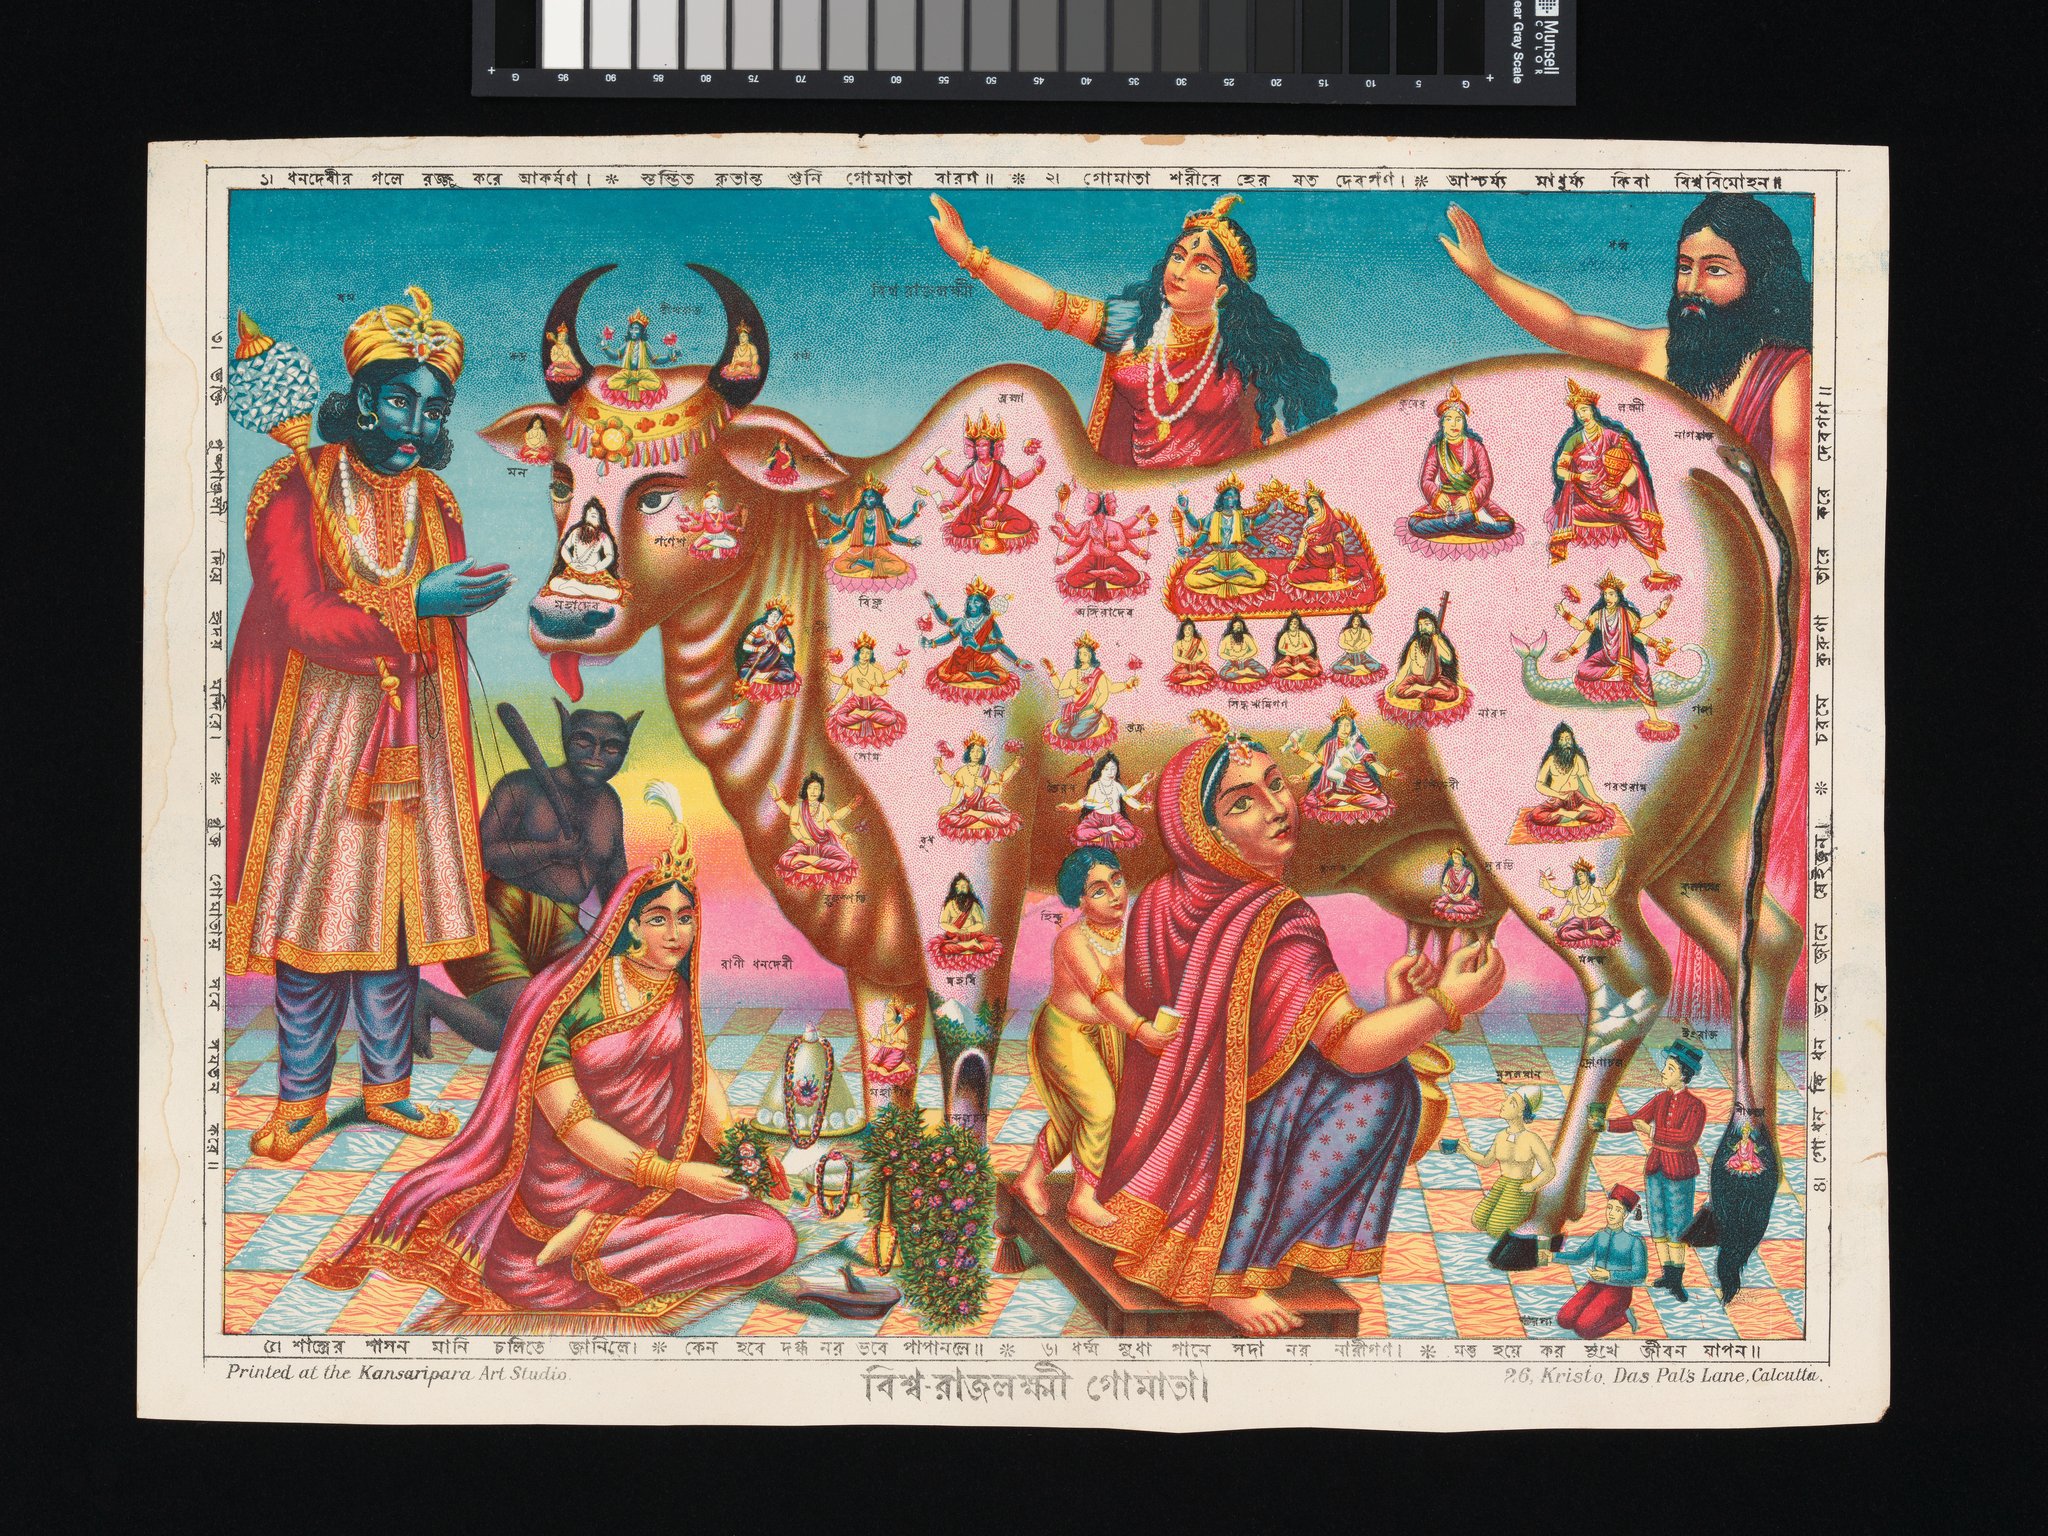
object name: lithograph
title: Vishva Rajalakshmi Gomata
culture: indian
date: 1890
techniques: lithograph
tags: men,women,cows